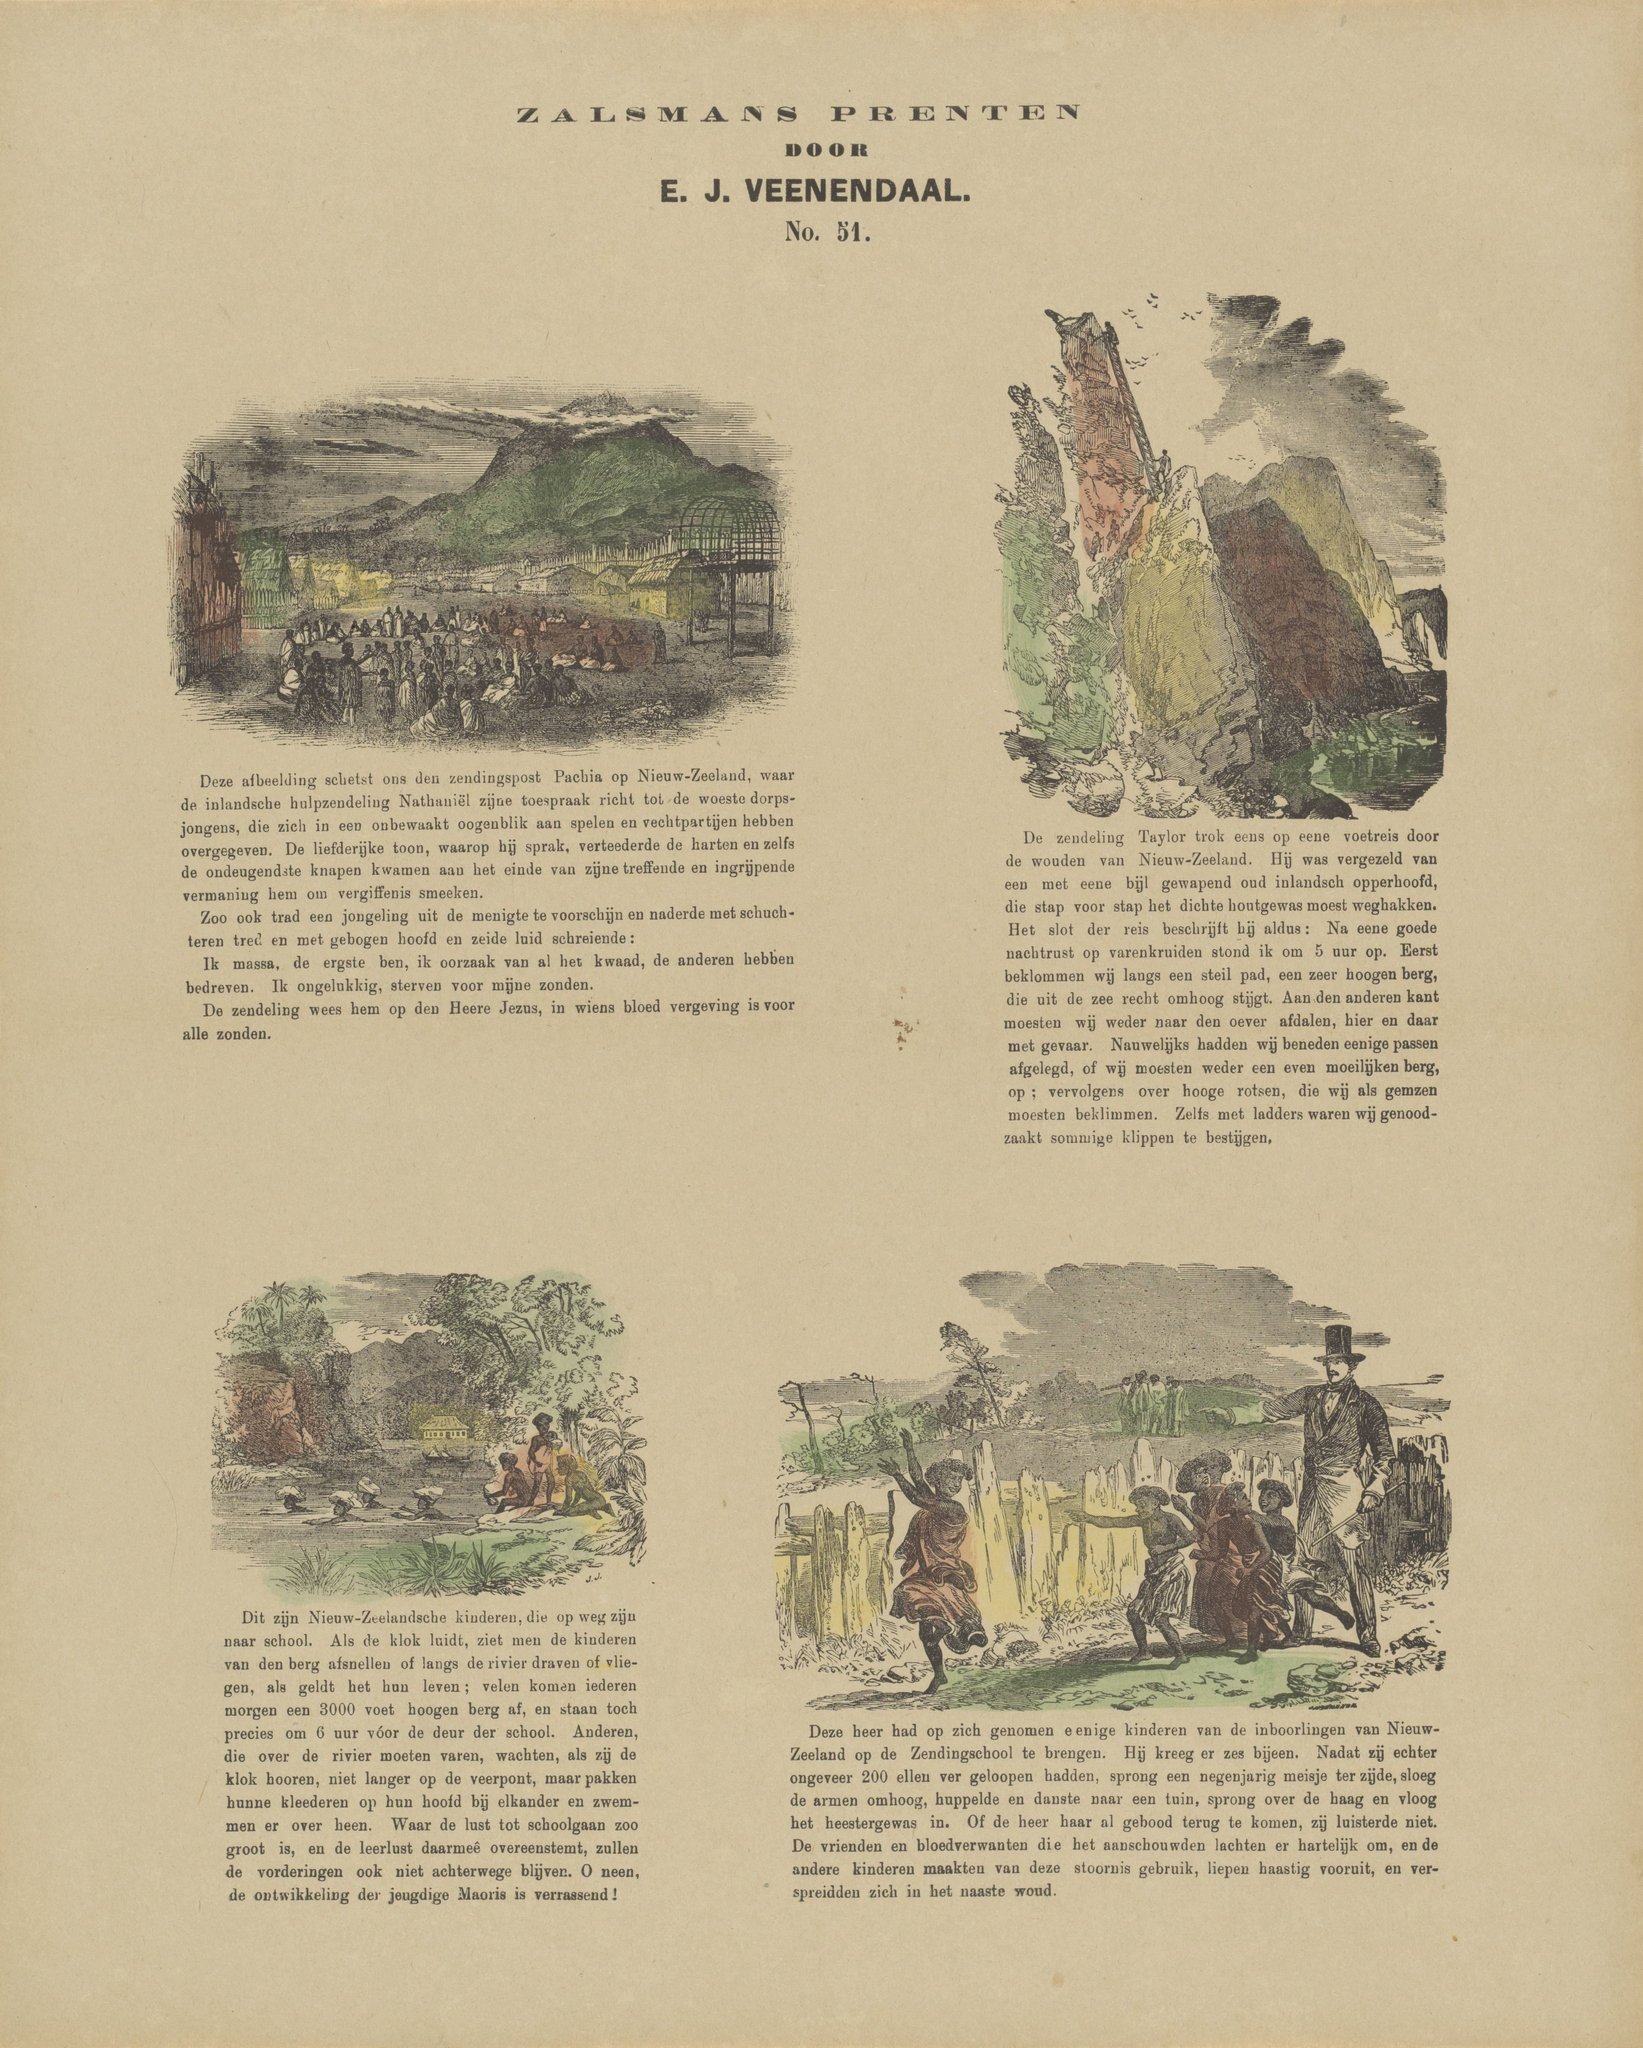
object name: print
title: Nieuw-Zeeland en Nieuw-Zeelanders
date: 1869-1882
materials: paper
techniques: colour, letterpress printing, engraving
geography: netherlands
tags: australian and oceanian races, new zealand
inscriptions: collector's mark: Lugt 2760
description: Blad met 4 voorstellingen van Nieuw-Zeeland en Nieuw-Zeelanders. Onder elke afbeelding een onderschrift. Genummerd midden boven: No. 51.